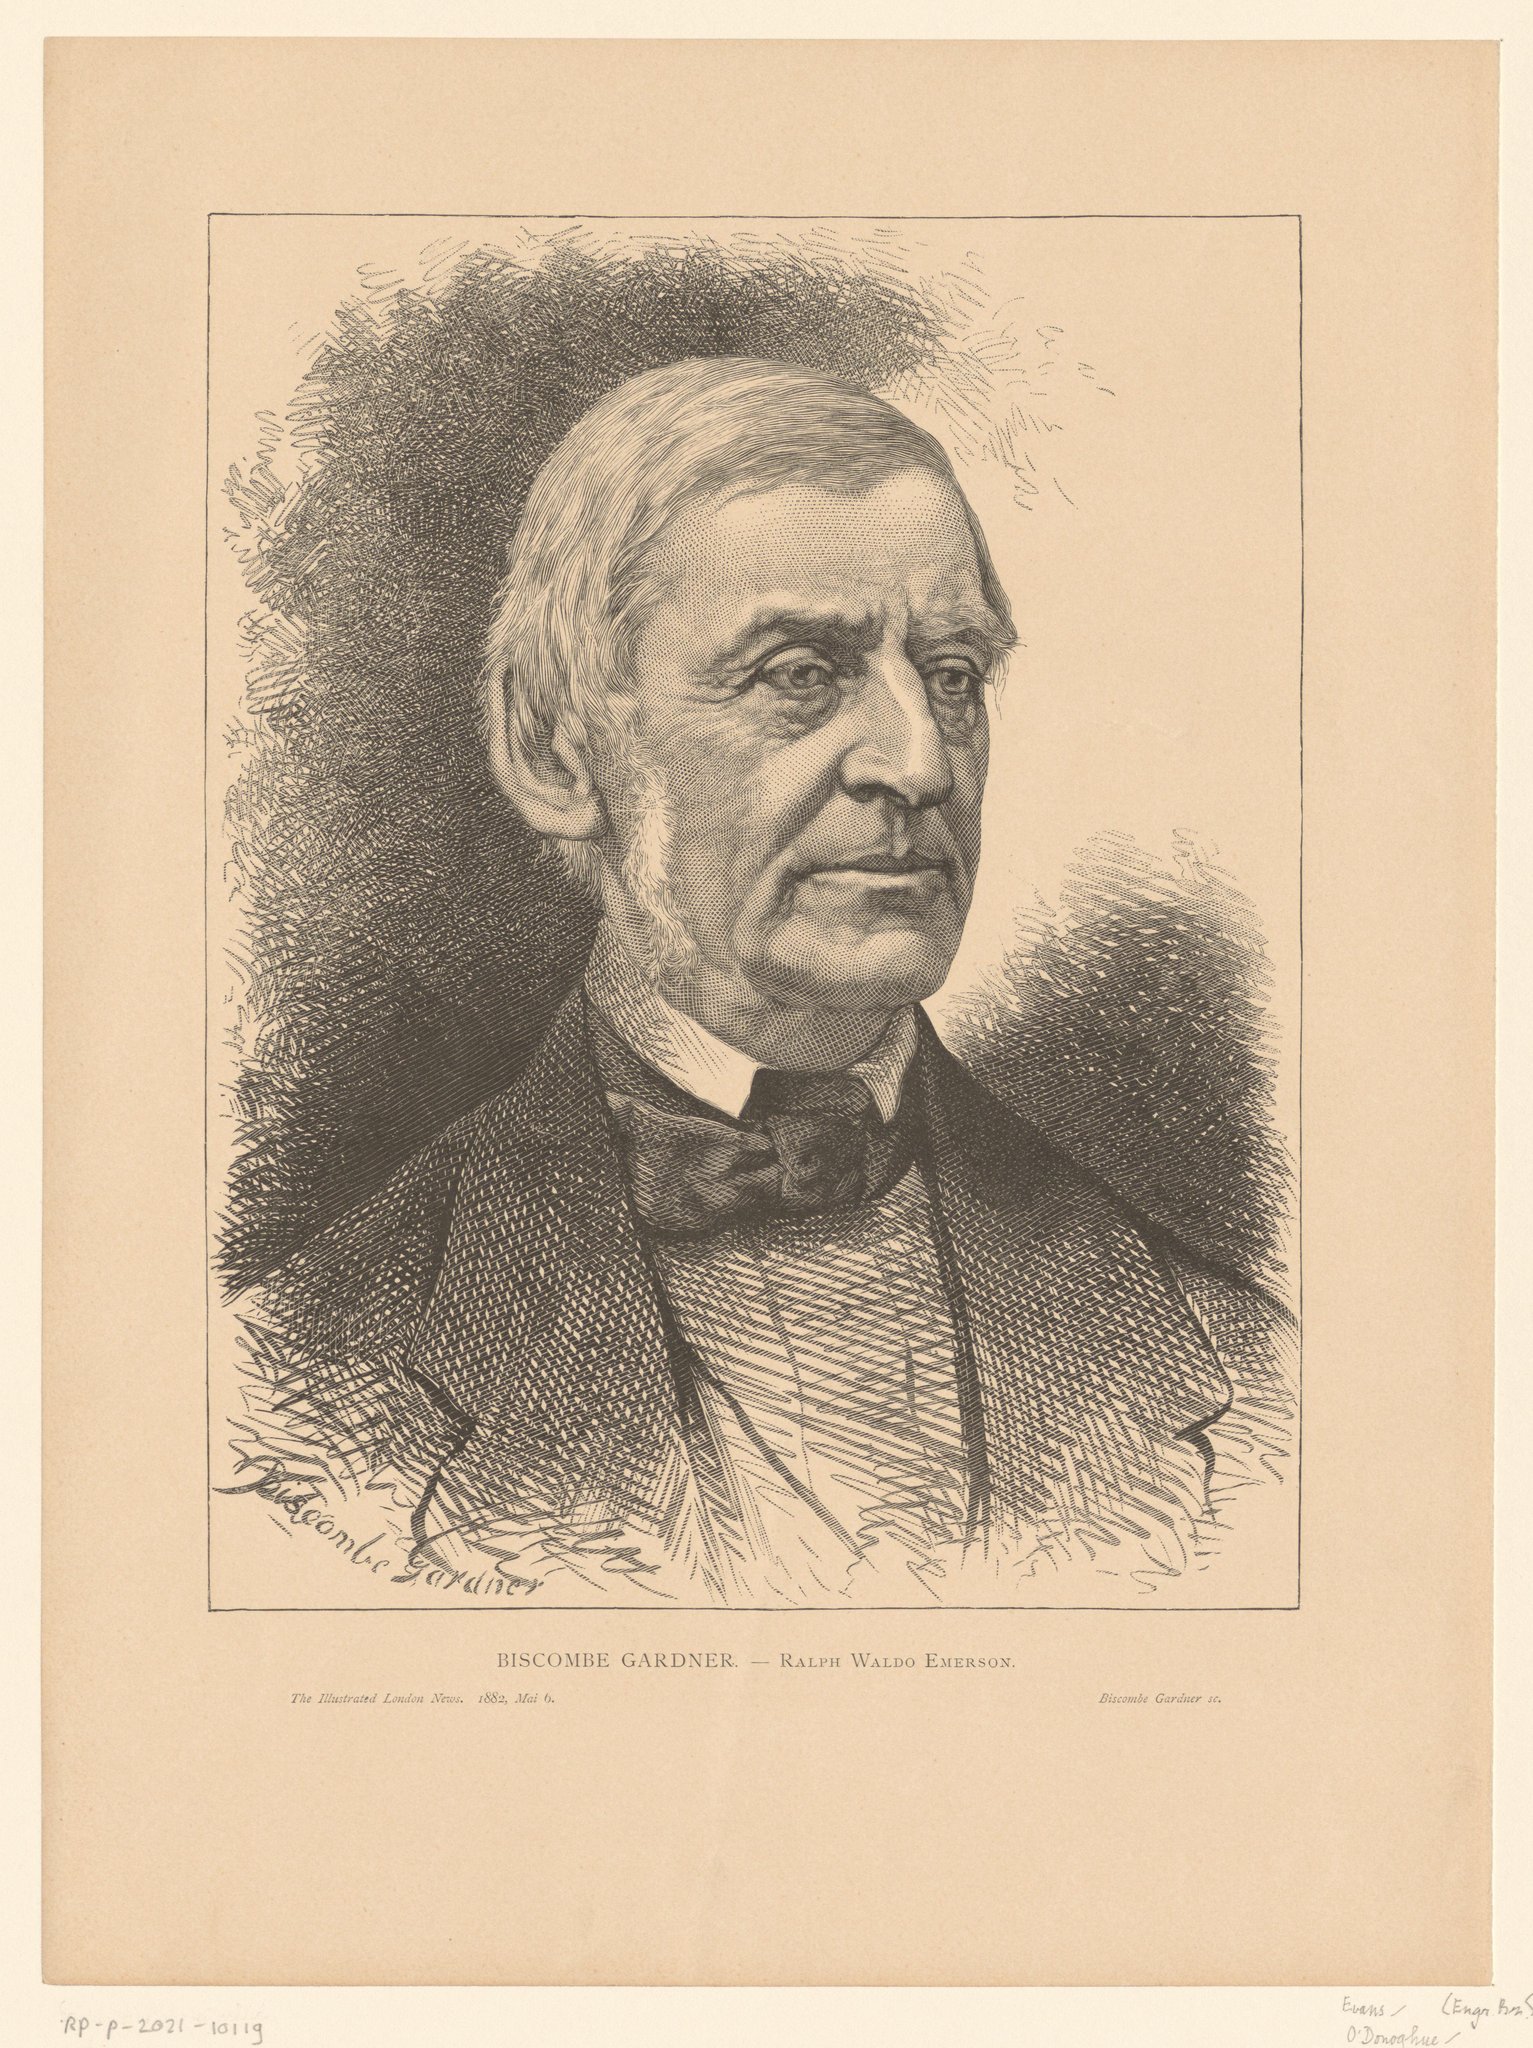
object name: print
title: Portret van Ralph Waldo Emerson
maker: william biscombe gardner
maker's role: print maker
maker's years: 1847-1919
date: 1882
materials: paper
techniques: engraving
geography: england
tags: historical persons, scholar, philosopher (+ portrait of scholar, scientist)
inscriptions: collector's mark: Lugt 2228, collector's mark: Lugt 3937